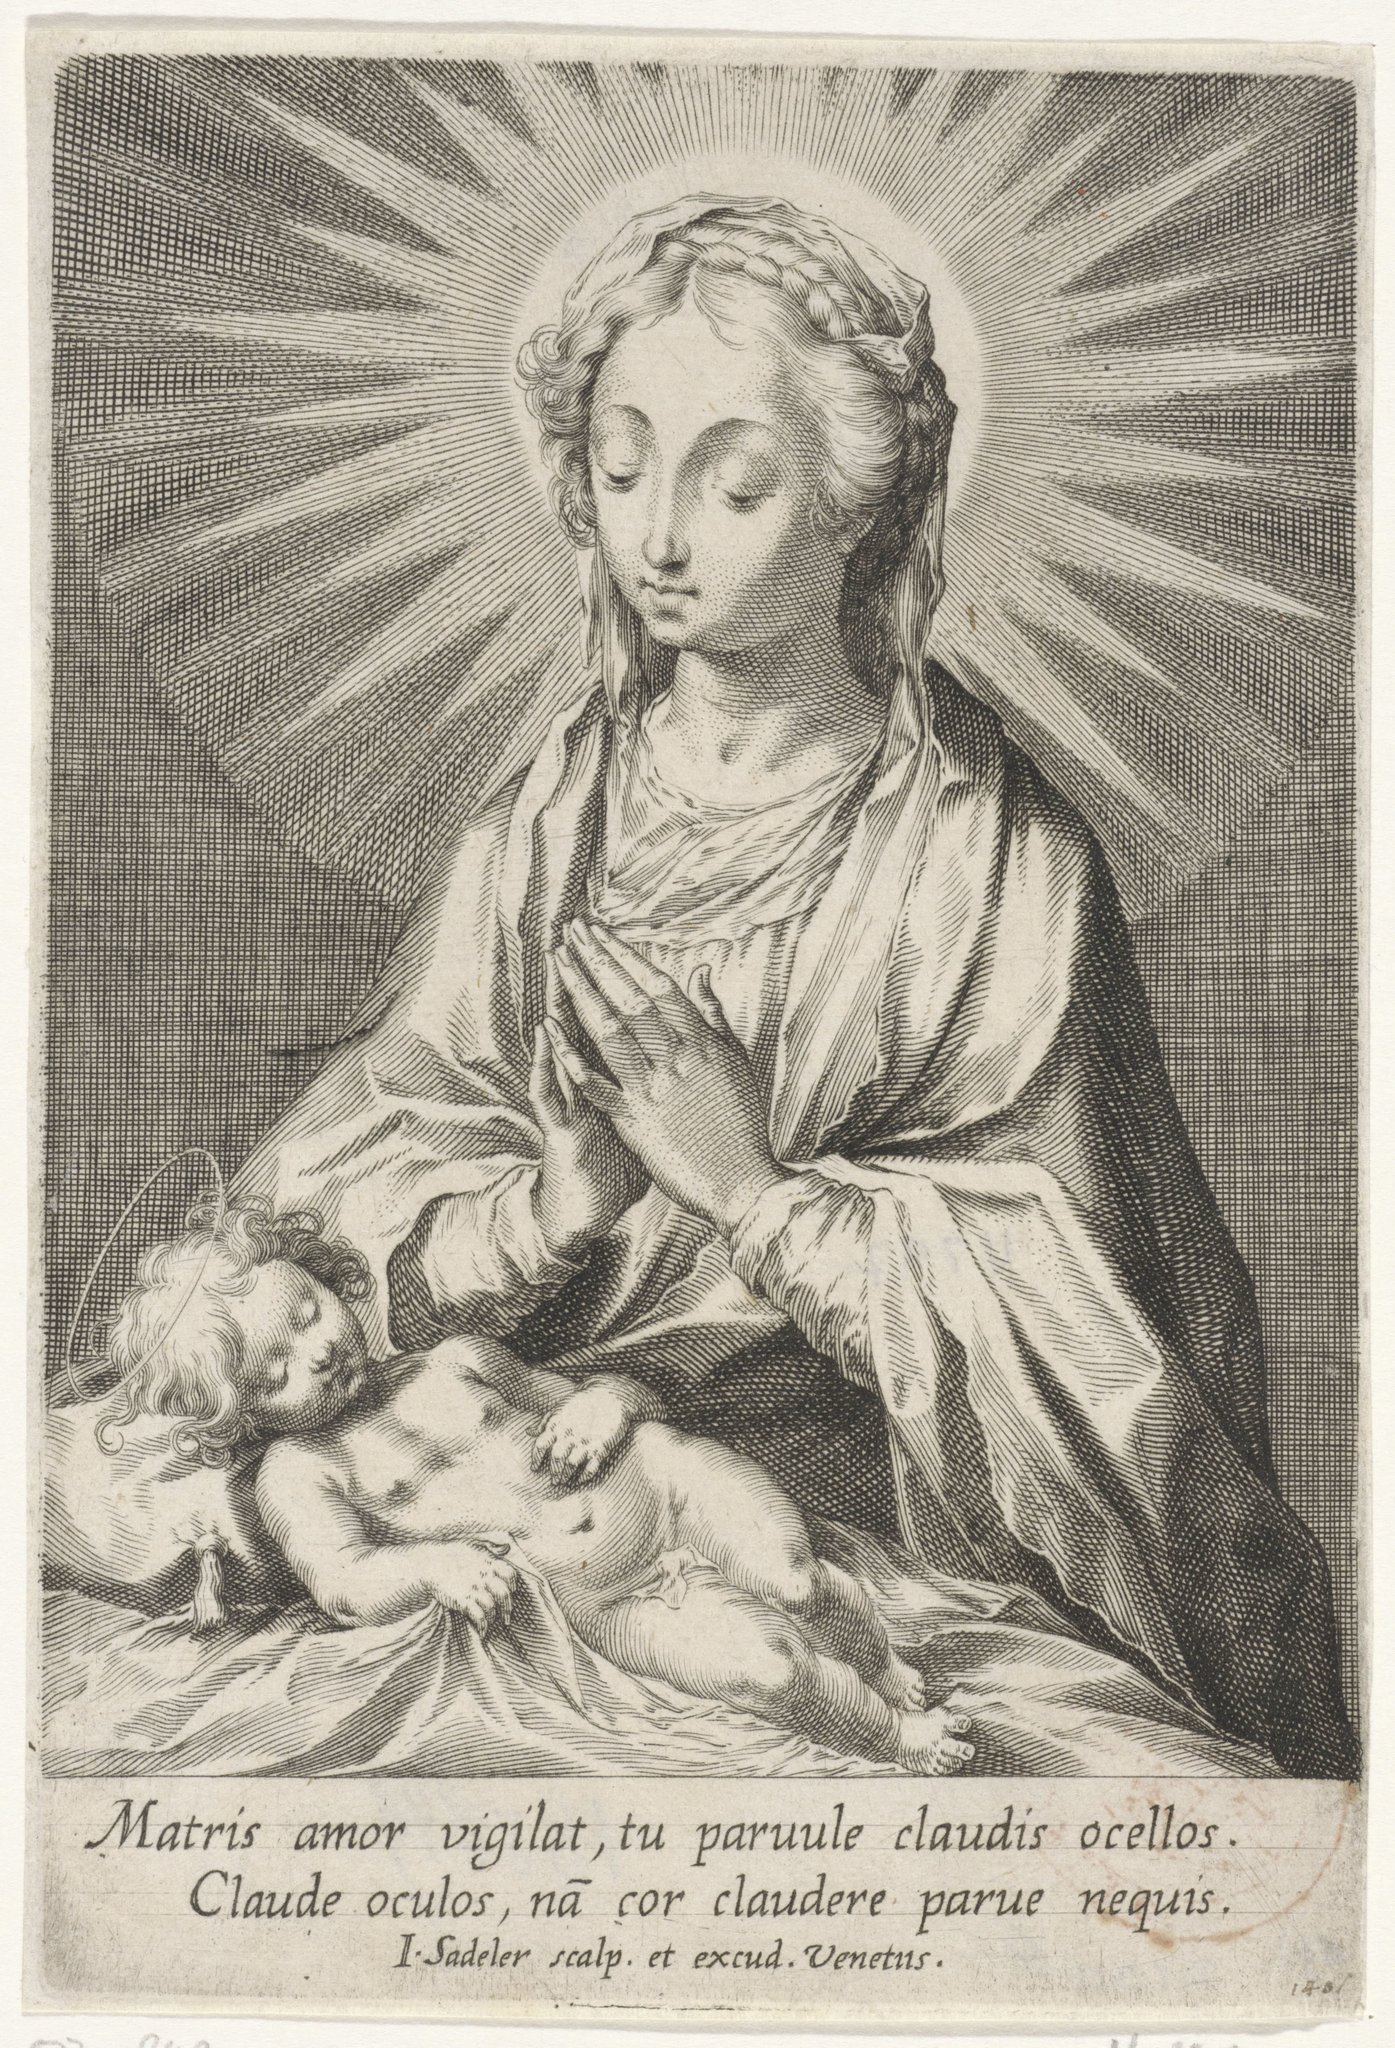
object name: print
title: Maria aanbidt het slapende Christuskind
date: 1595-1600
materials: paper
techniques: engraving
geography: venice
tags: adoration of the christ-child by mary, mary kneeling (on the ground), the christ-child in front of her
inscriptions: collector's mark: Lugt 240, number: ‘14 o.’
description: De maagd Maria aanbidt het slapende Christuskind.